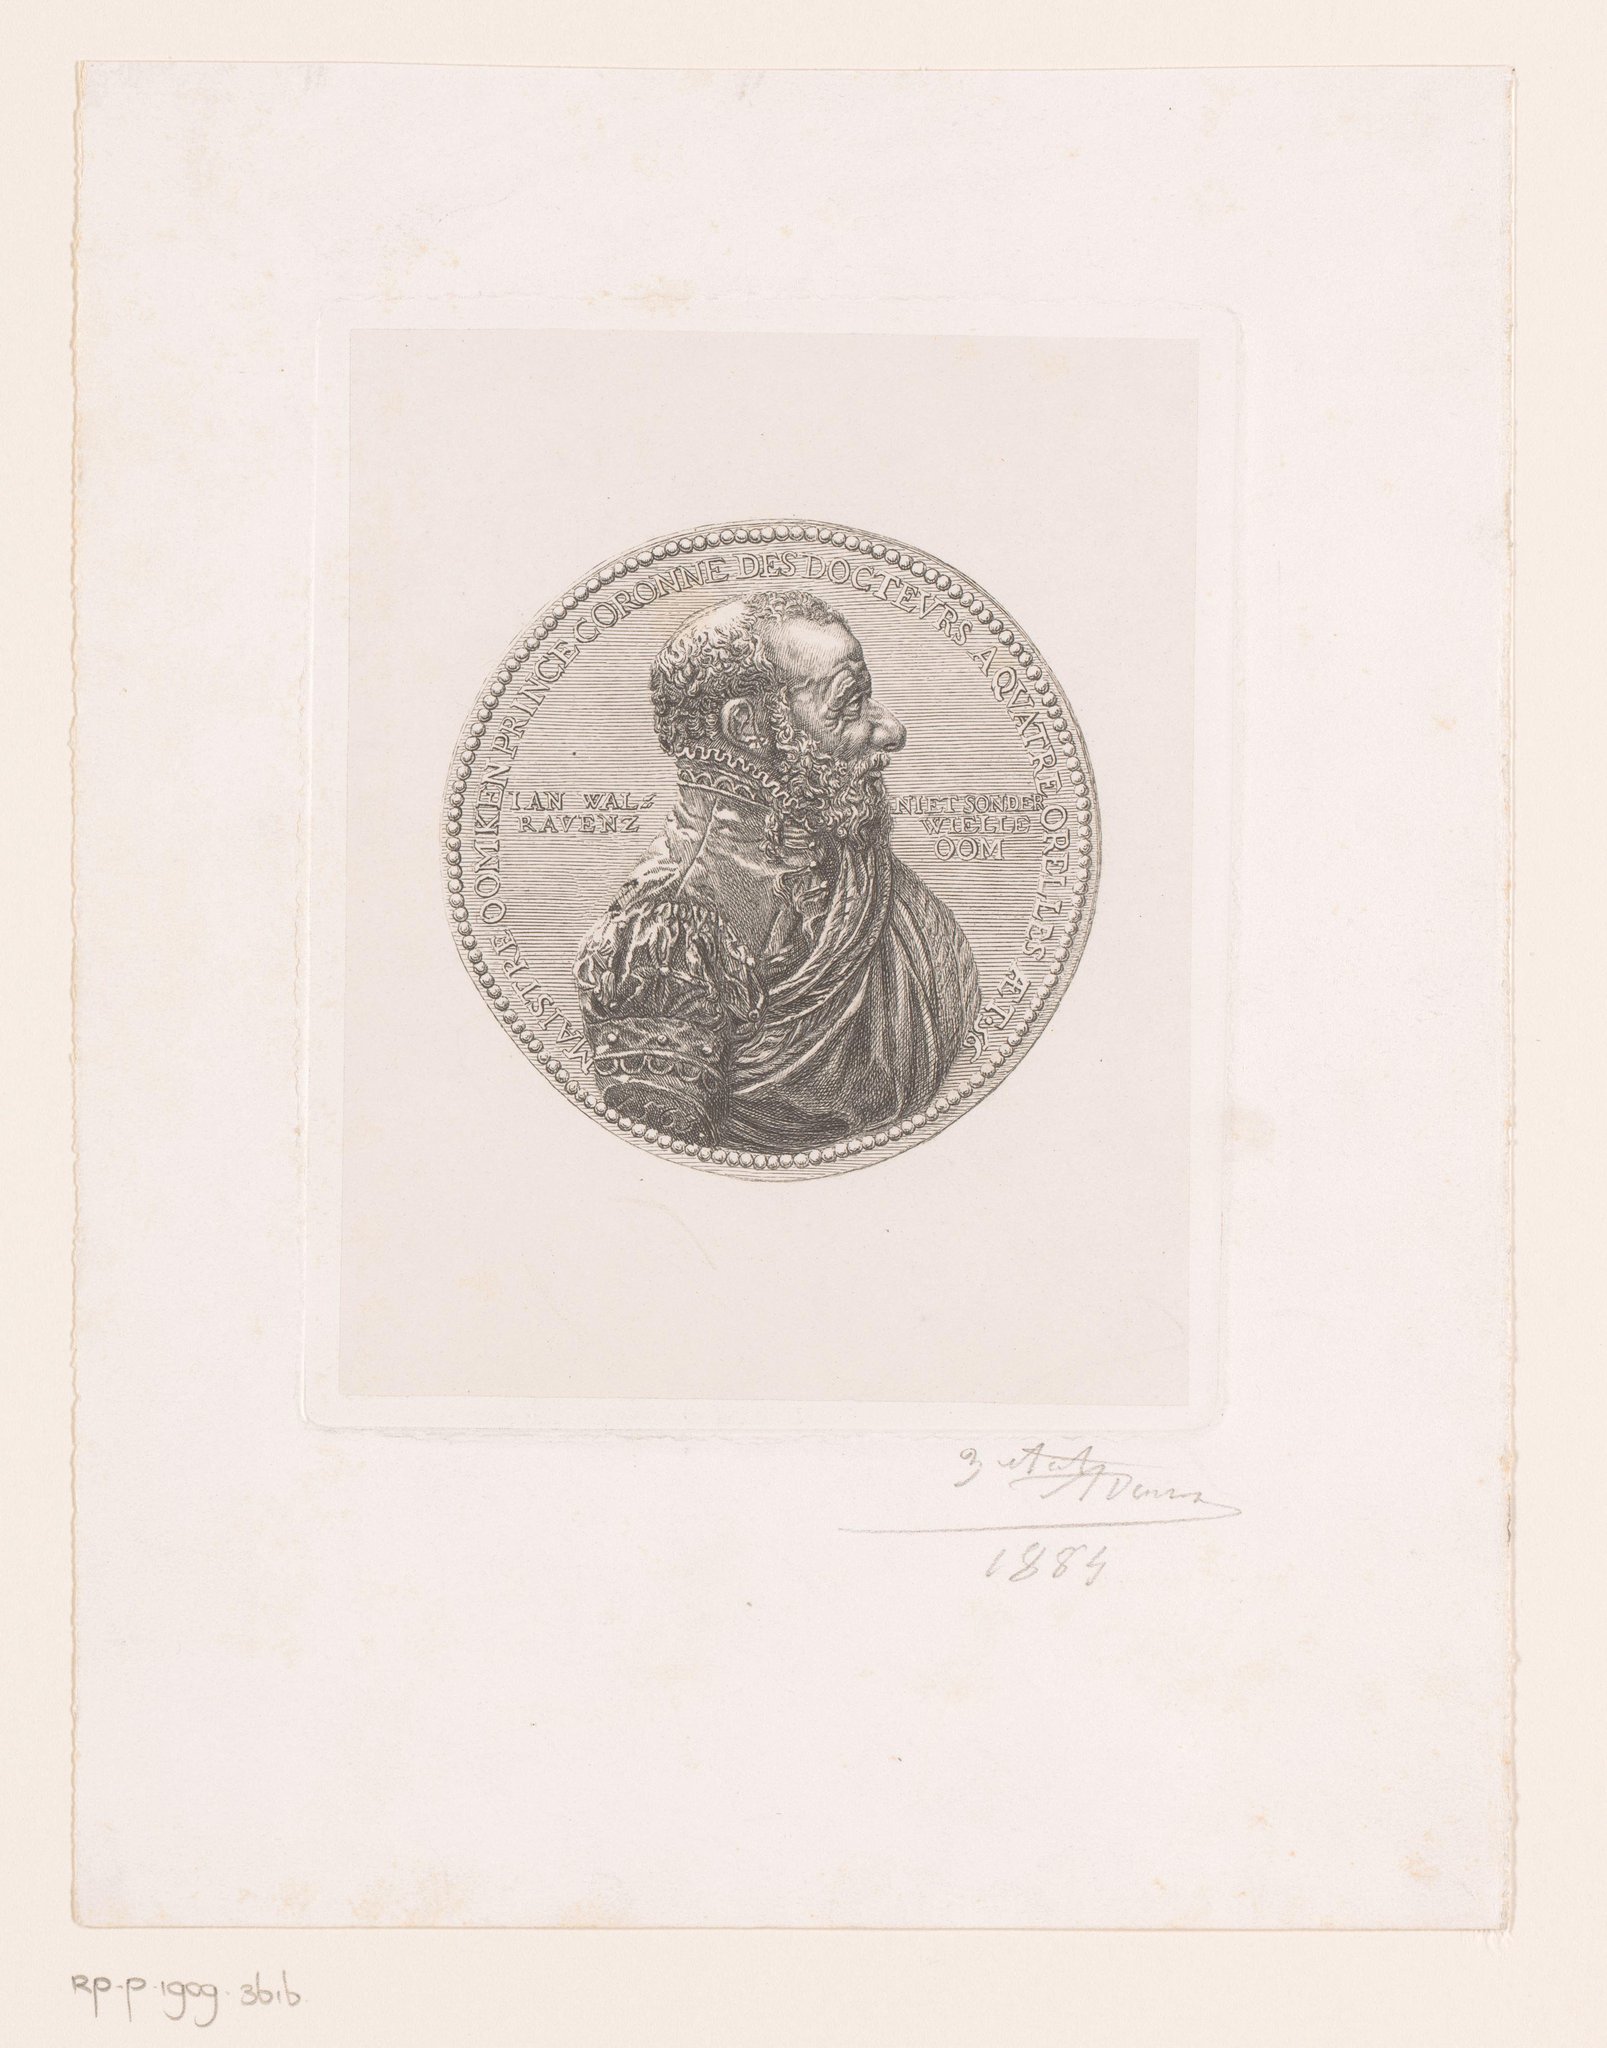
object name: print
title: Medaille met portret van Jan Walravenz uit 1563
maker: auguste danse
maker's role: print maker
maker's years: 1829-1929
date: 1884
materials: paper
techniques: etching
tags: historical person (...) - historical person (...) portrayed alone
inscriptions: collector's mark: Lugt 2228, annotation: ‘3 etat’